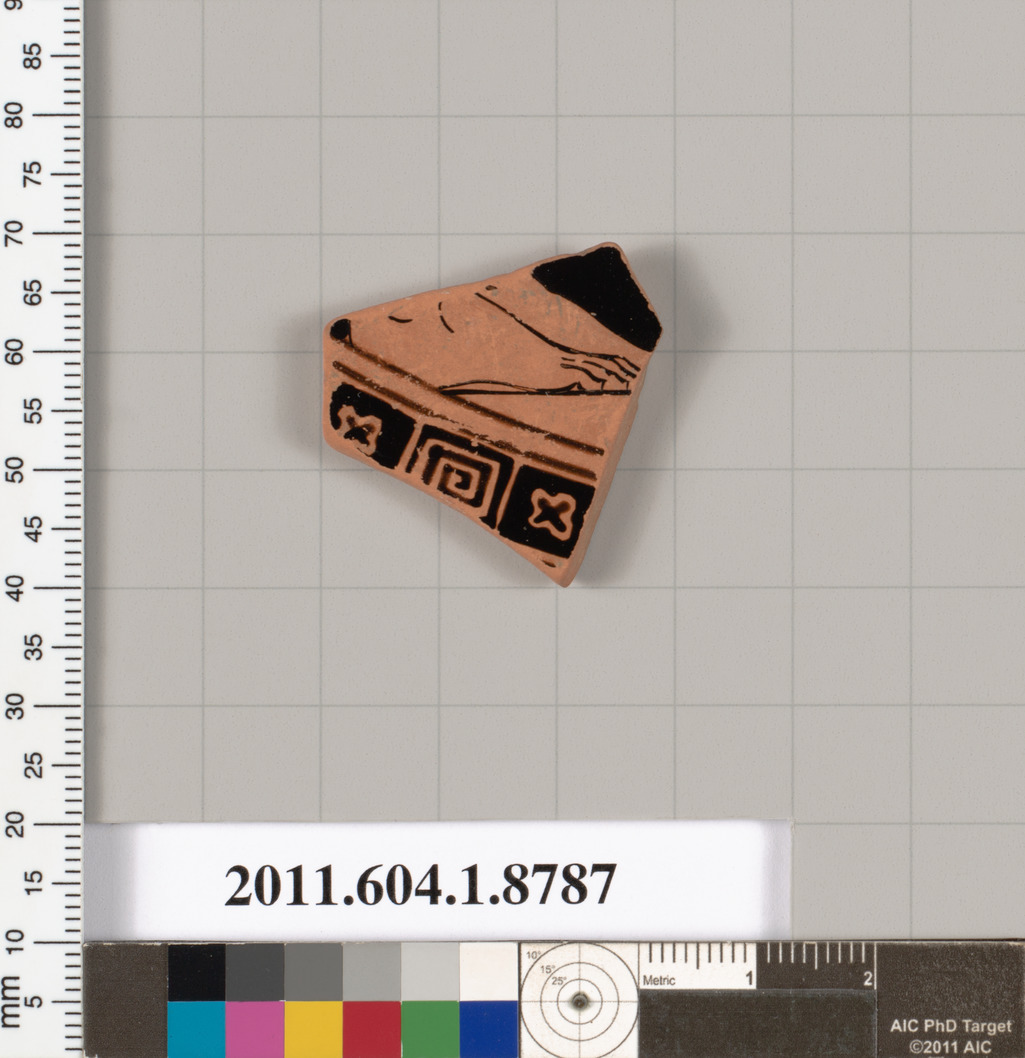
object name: kylix fragment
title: Terracotta fragment of a kylix (drinking cup)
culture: greek, attic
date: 490-480 BCE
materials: terracotta